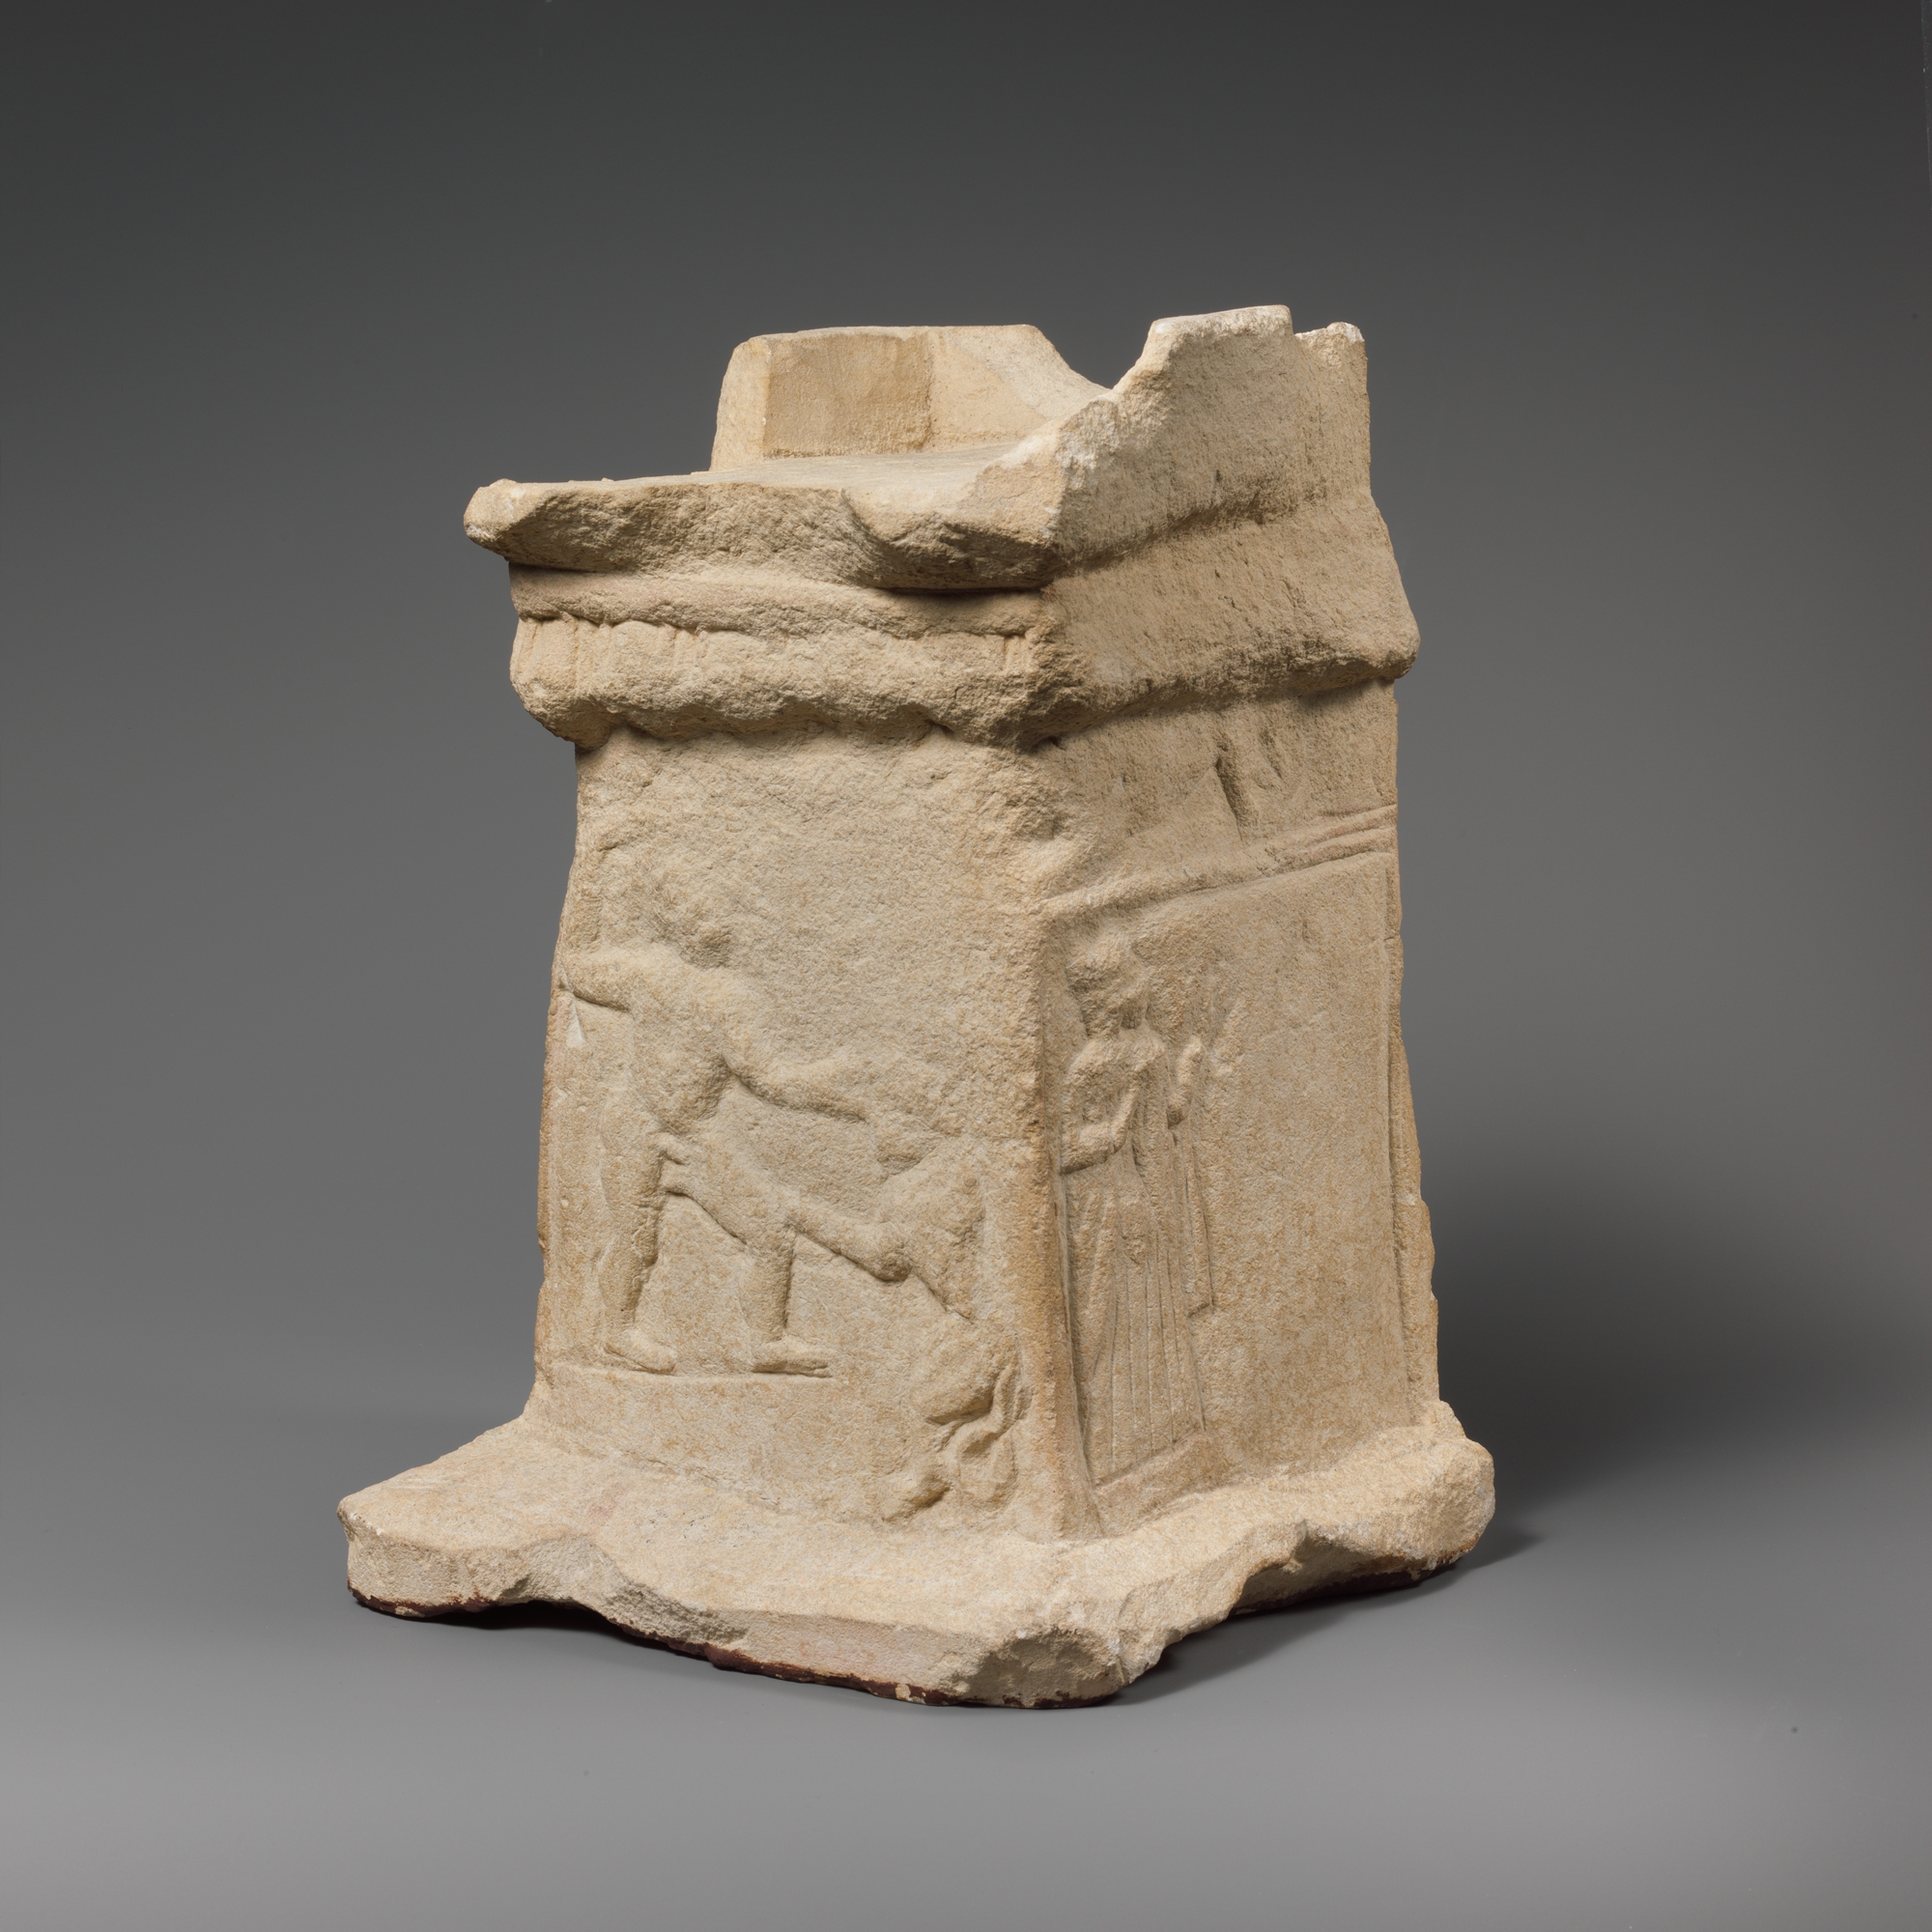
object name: altar, four sided, decorated with scene in relief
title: Limestone altar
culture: cypriot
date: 434-401 BCE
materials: limestone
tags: women,lions,herakles